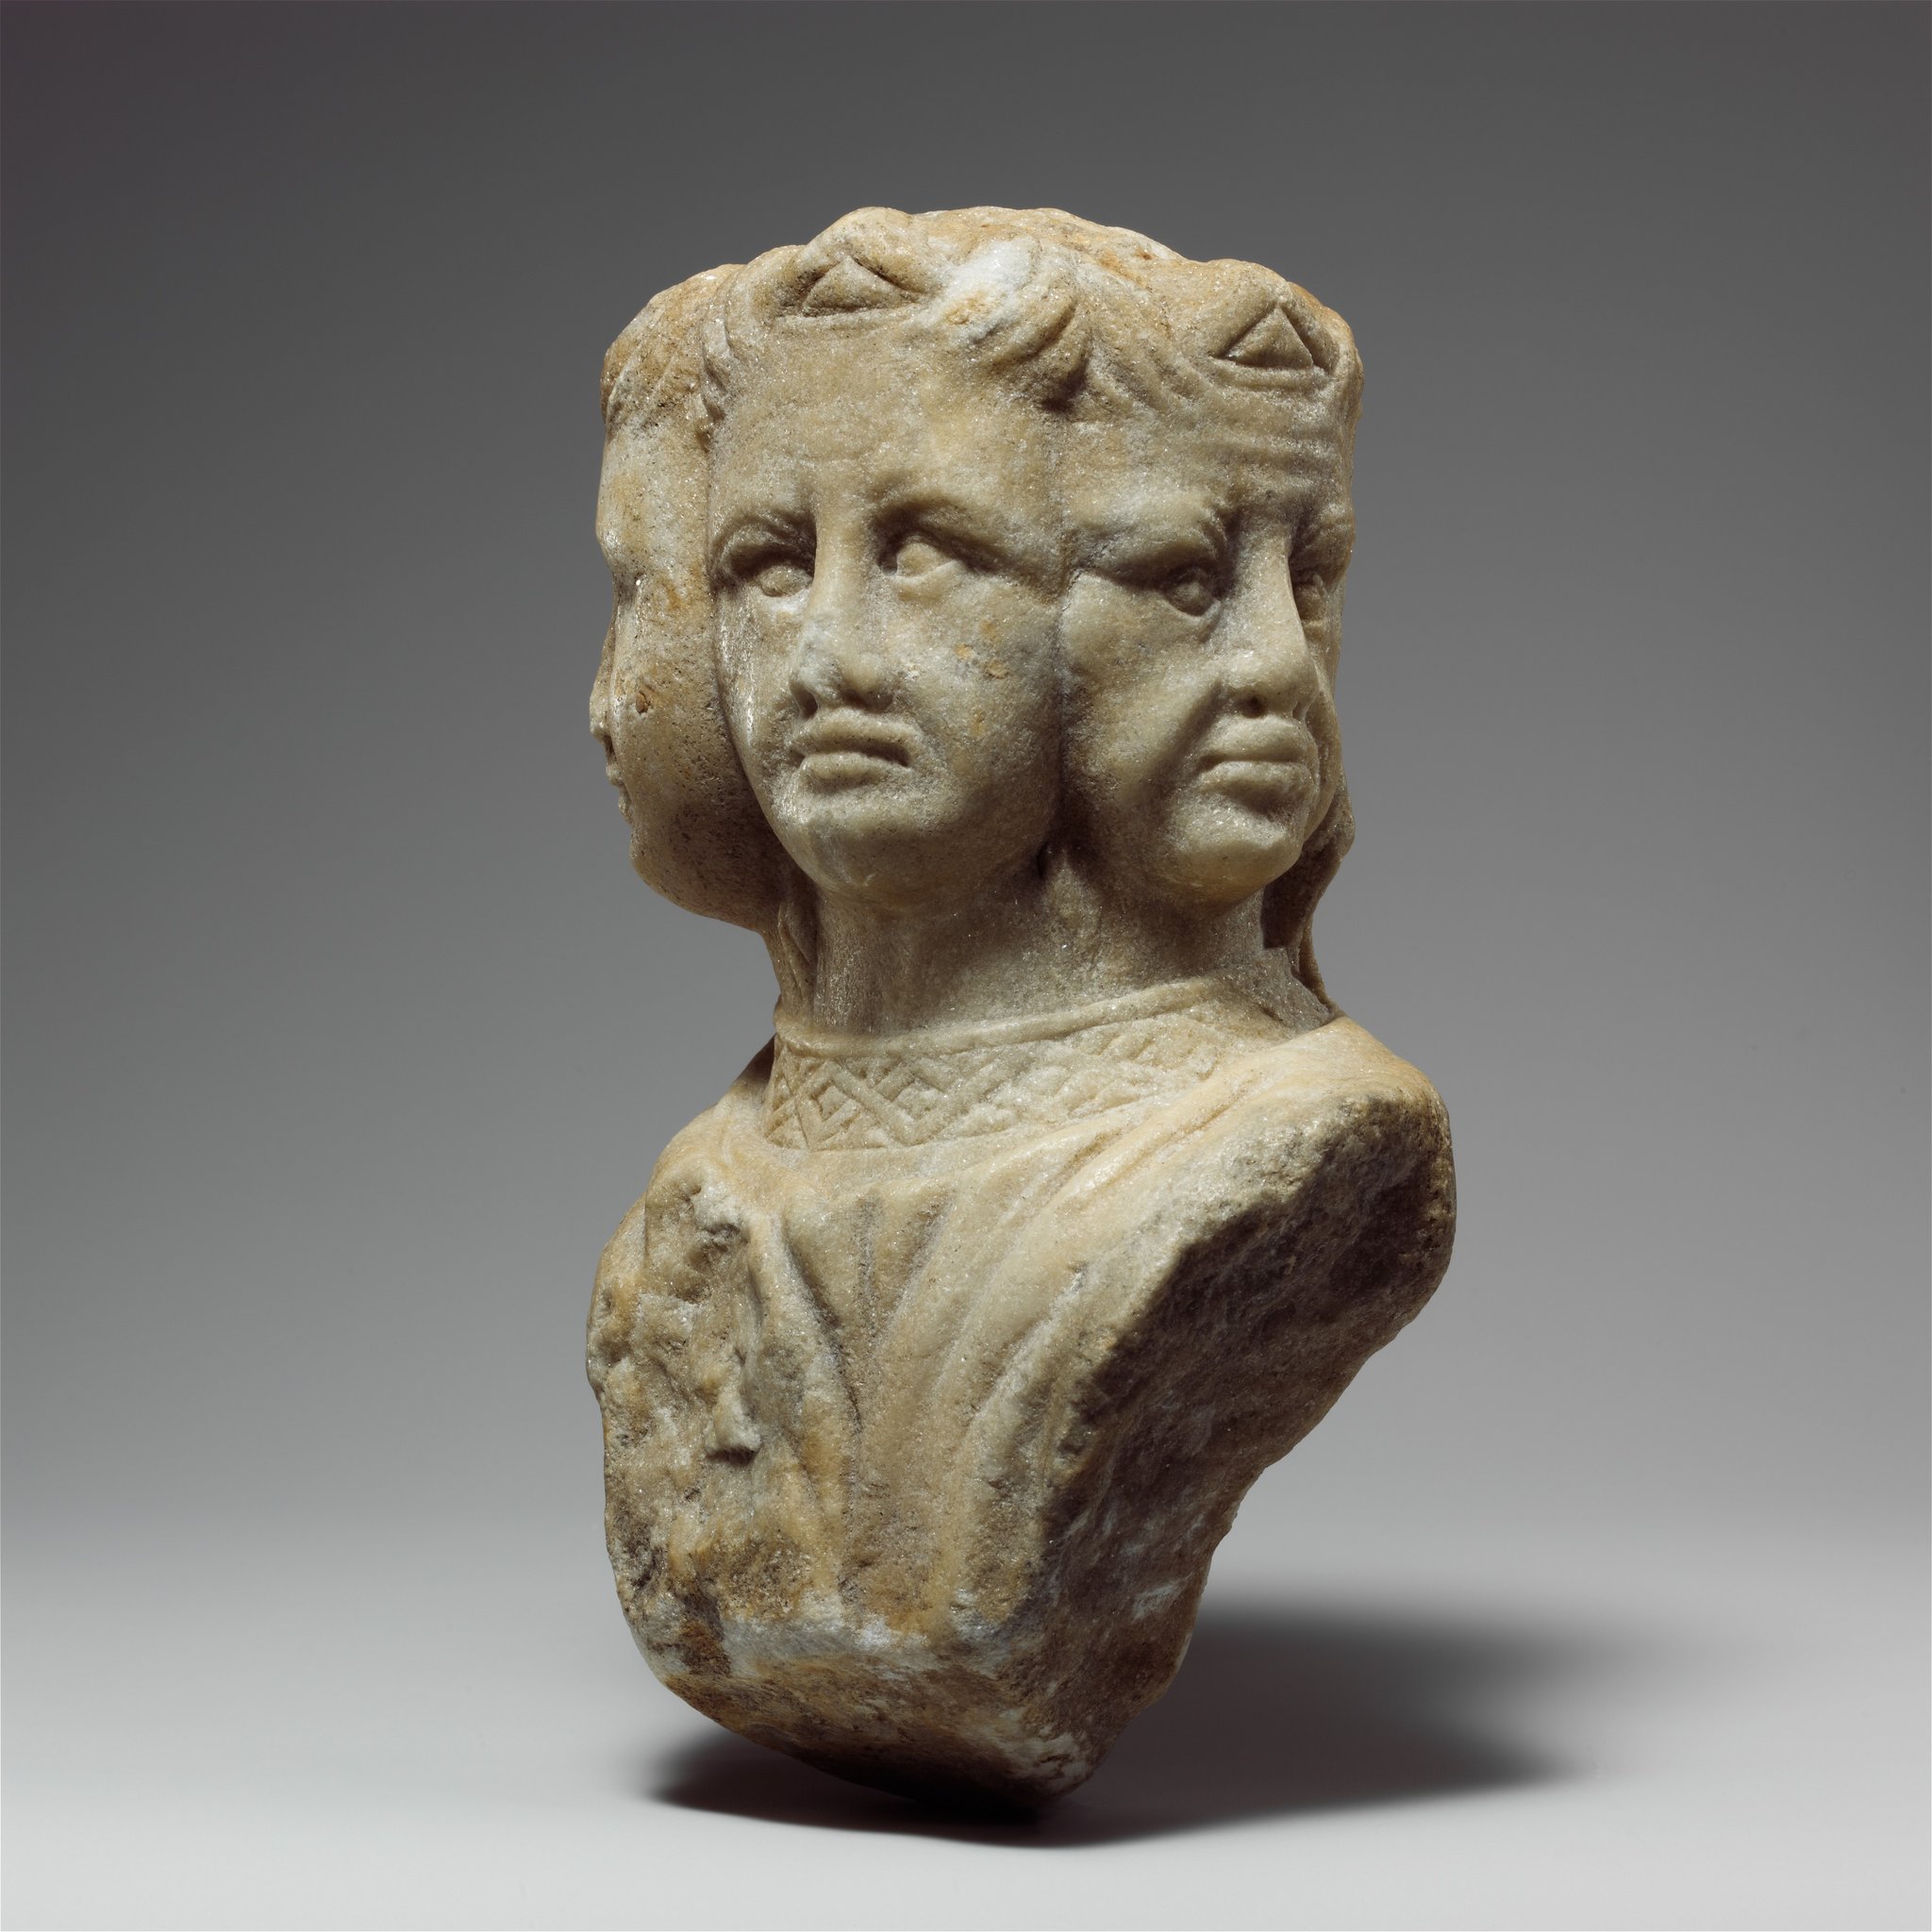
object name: sculpture fragment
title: Vultus trifrons or an Allegory of Prudence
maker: pacio bertini da firenze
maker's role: artist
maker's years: 1325-1351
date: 1340-1355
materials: marble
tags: faces